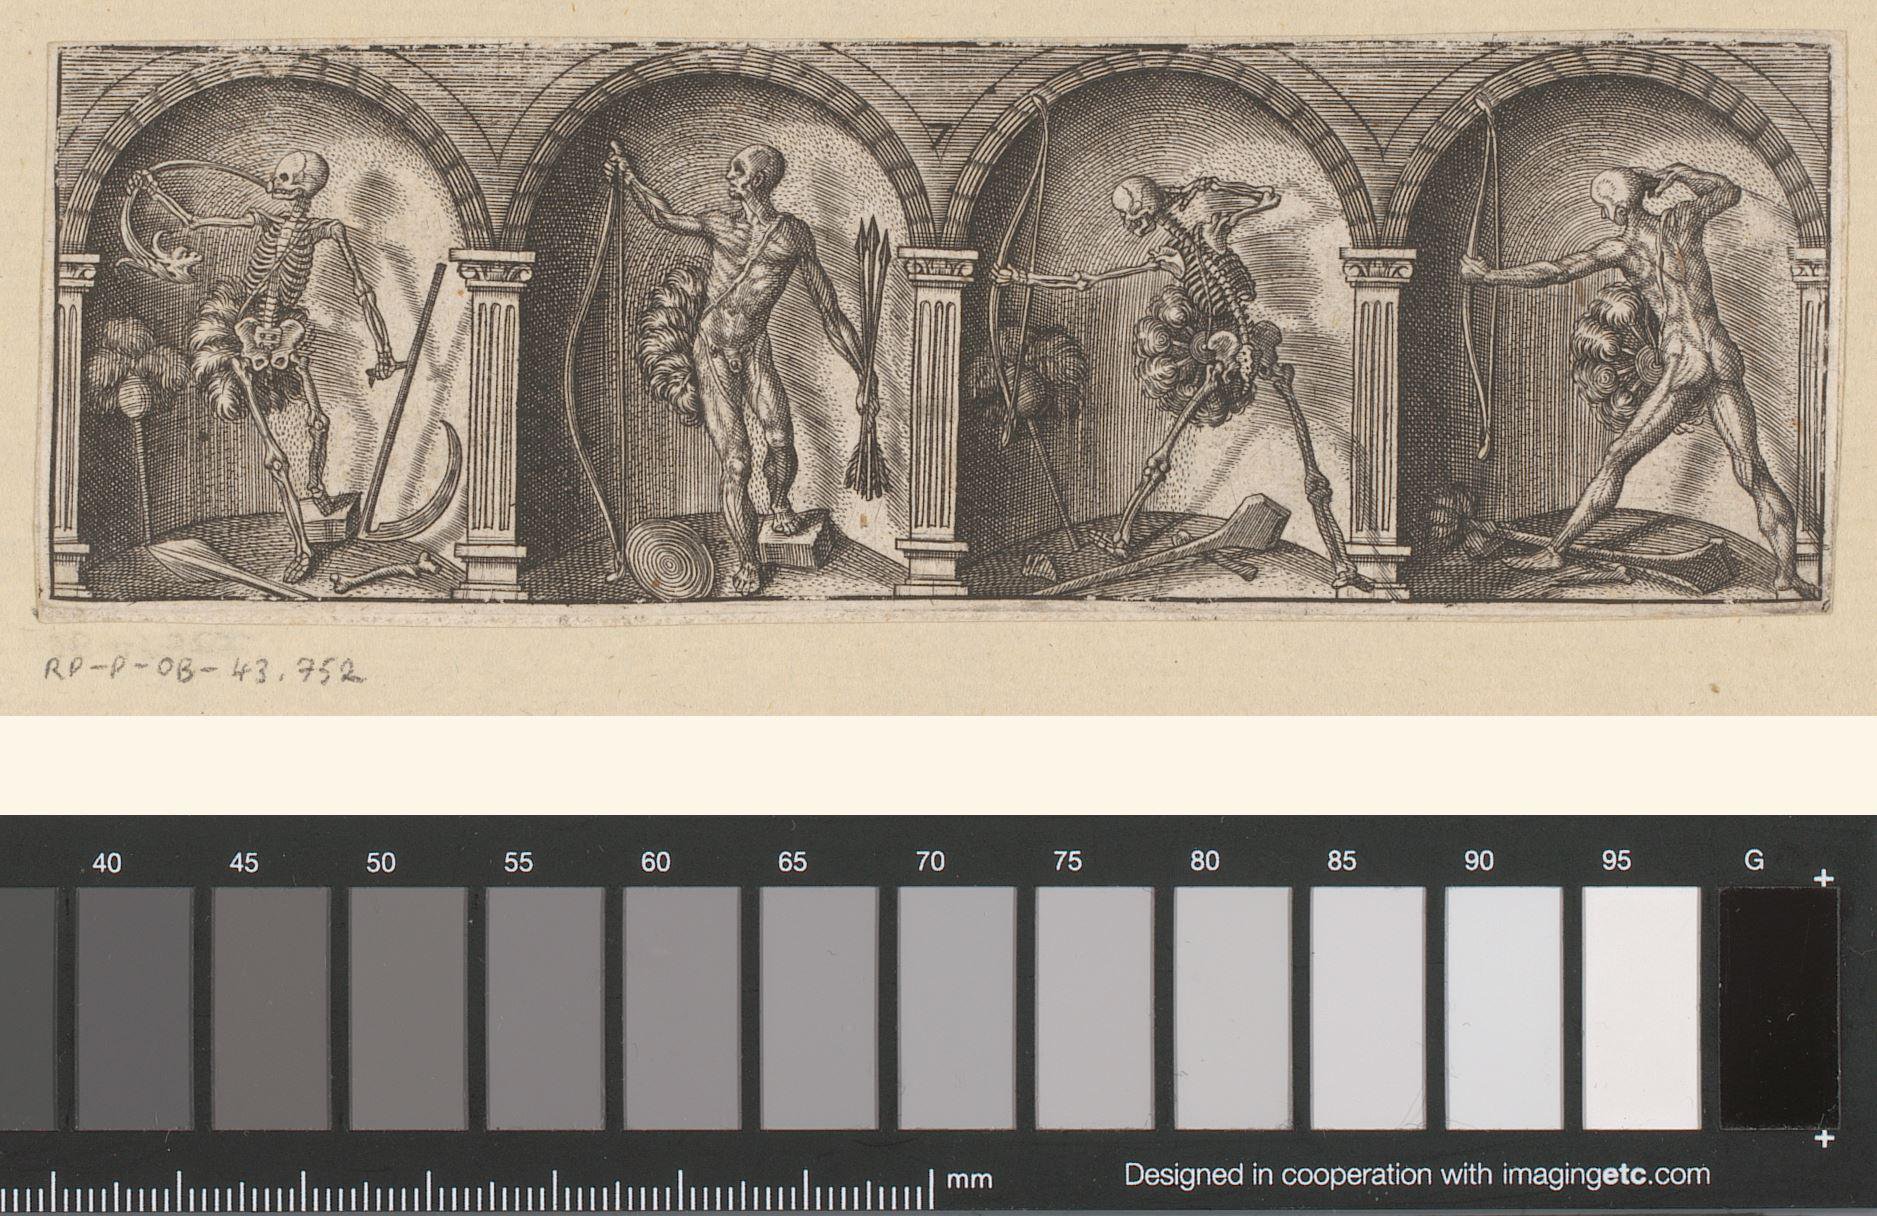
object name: print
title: Houdingen van boogschutters in verschillende stadia van ontleding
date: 1610-1640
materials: paper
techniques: engraving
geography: france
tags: parts of church interior: niche, decomposition (of dead body), archer's weapons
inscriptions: collector's mark: Lugt 240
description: In deze serie worden naakte figuren in vier architecturale niches geplaatst. Zij stellen de inwoners voor van de Nieuwe Wereld.